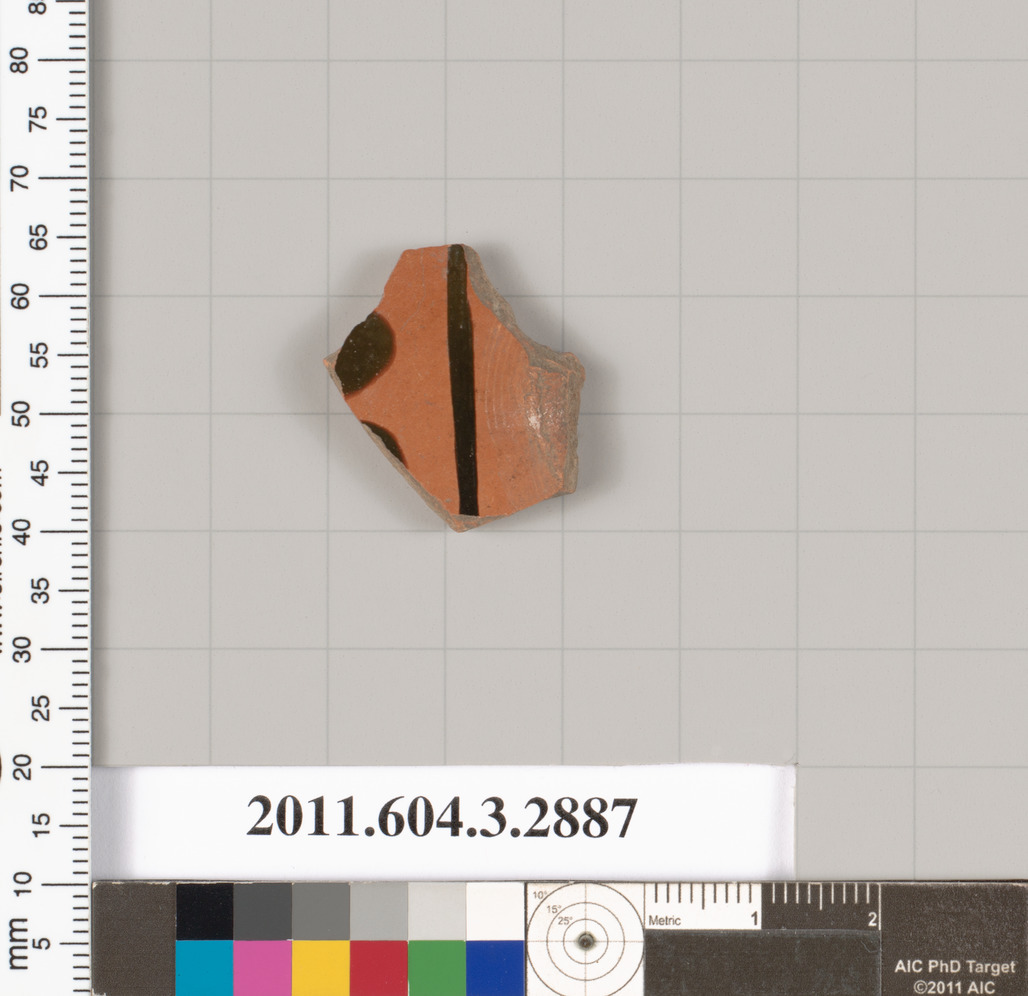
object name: neck amphora fragment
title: Terracotta fragment of a neck-amphora (jar)?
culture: greek, attic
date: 550-501 BCE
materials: terracotta